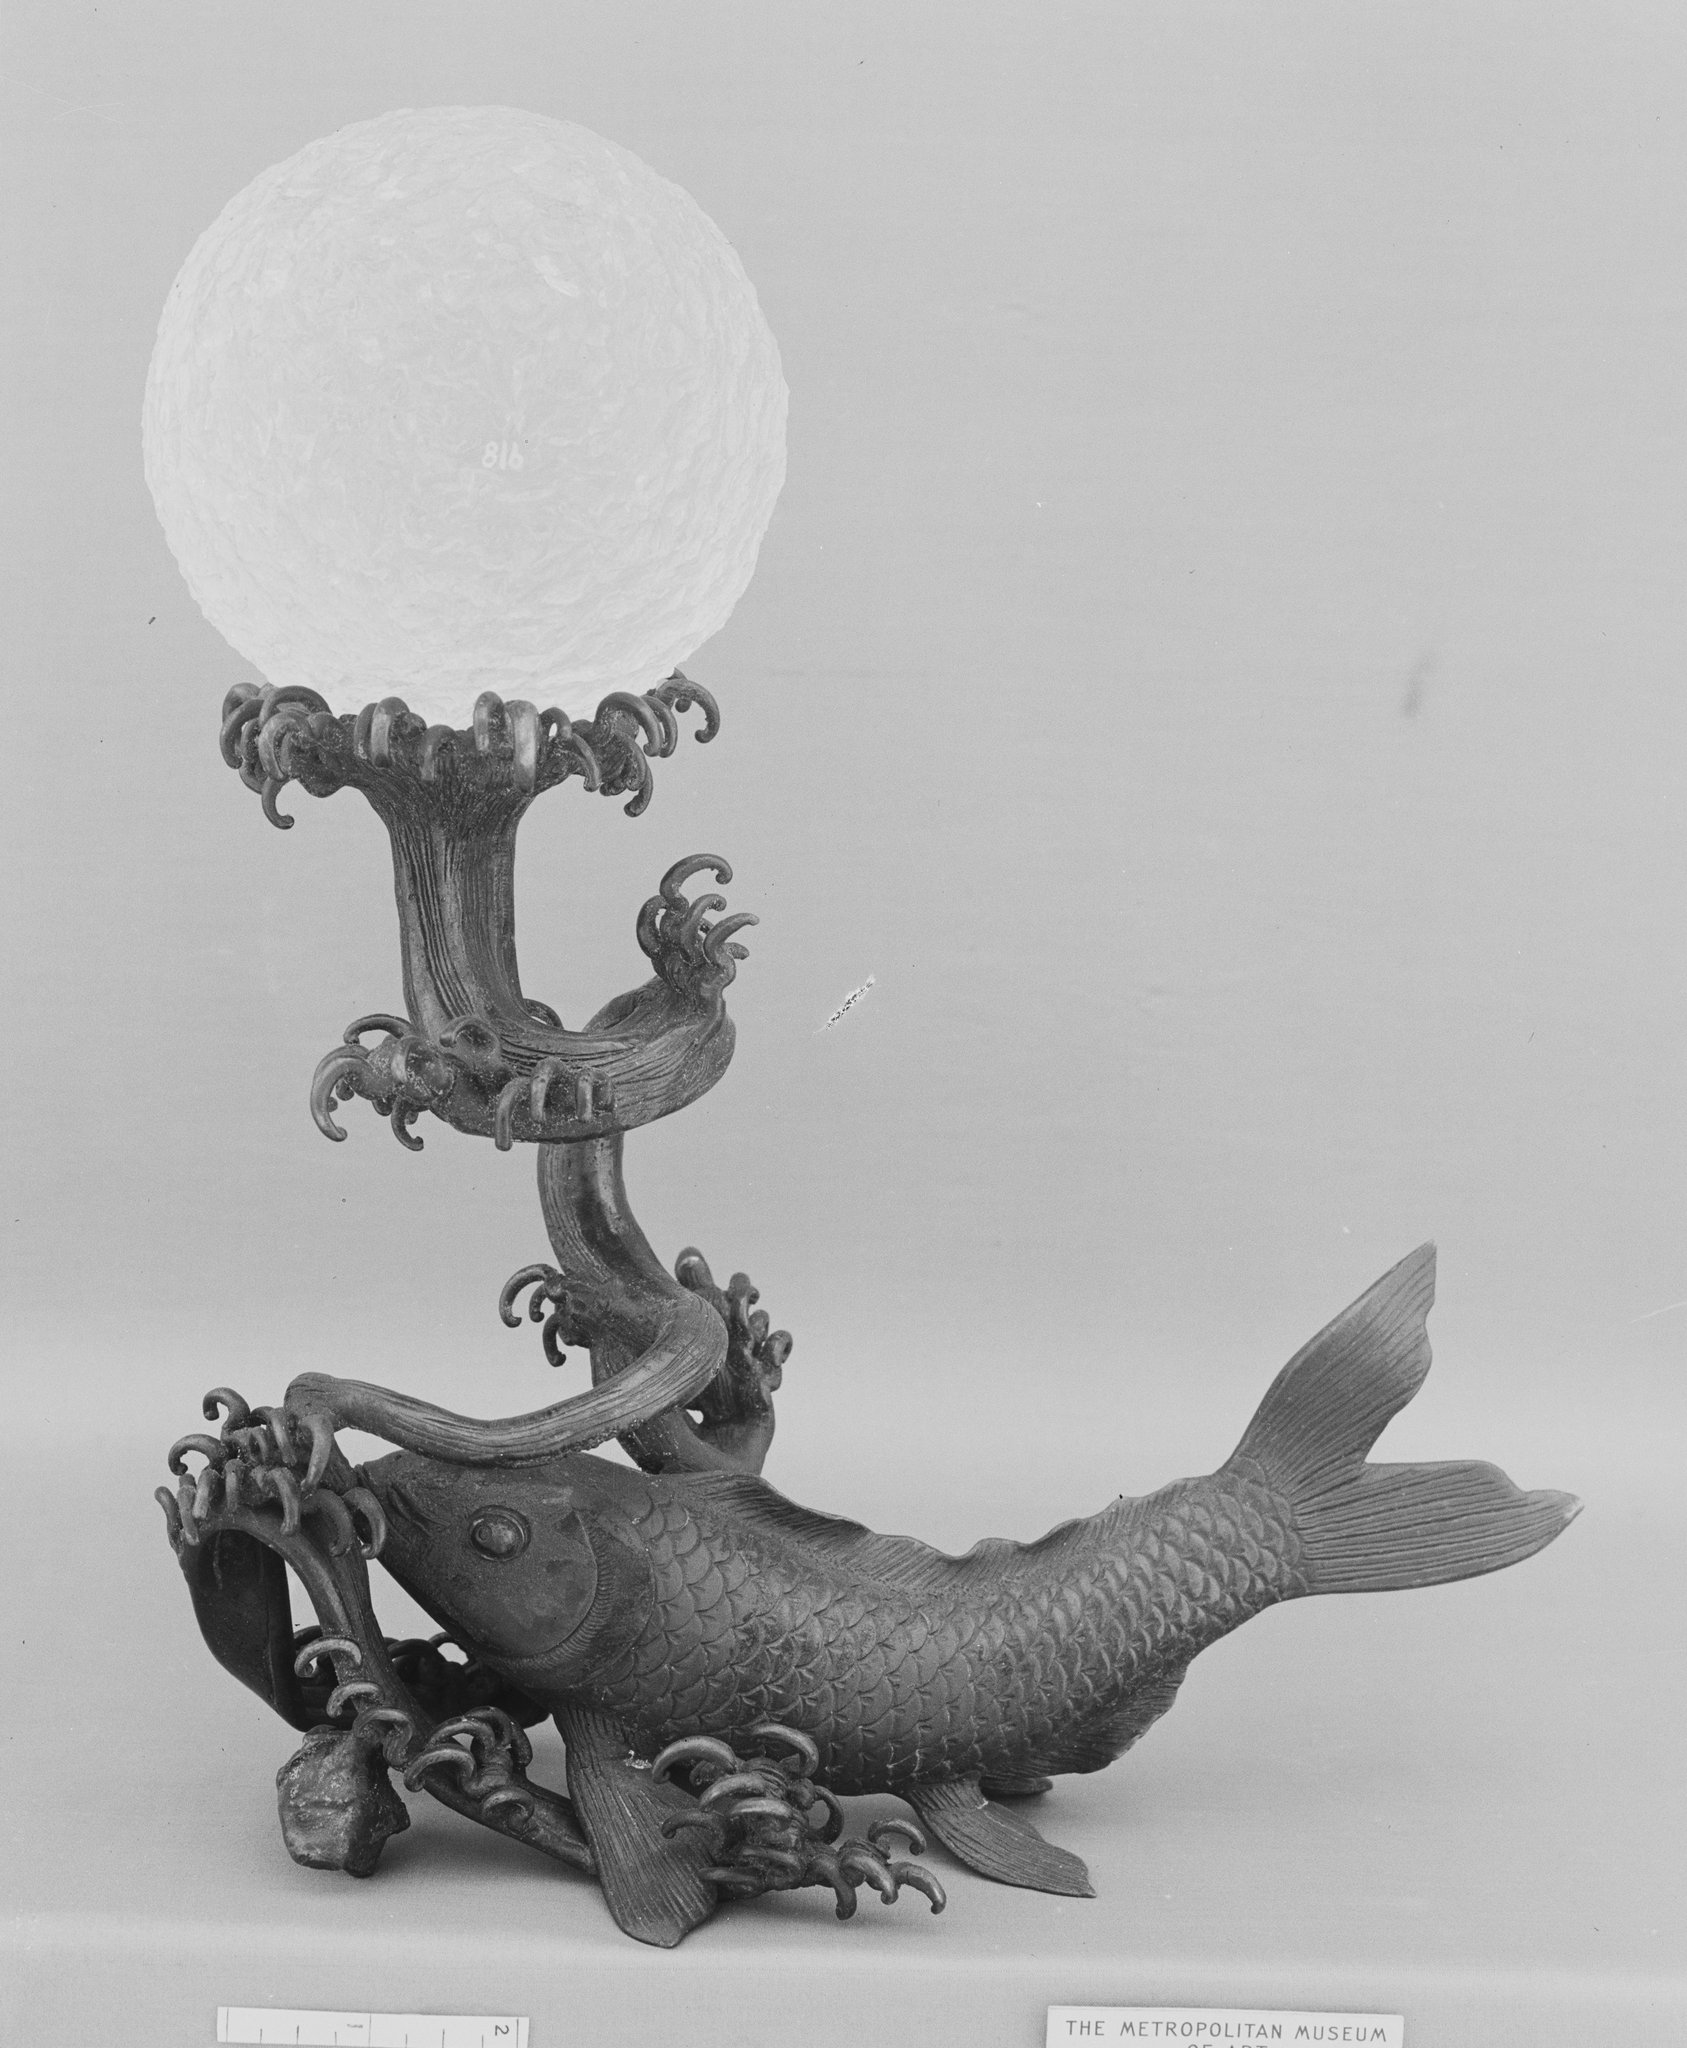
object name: crystal ball on stand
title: Crystal Ball on a Bronze Stand in the Shape of a Fish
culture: chinese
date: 1701-1800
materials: bronze, quartz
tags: fish